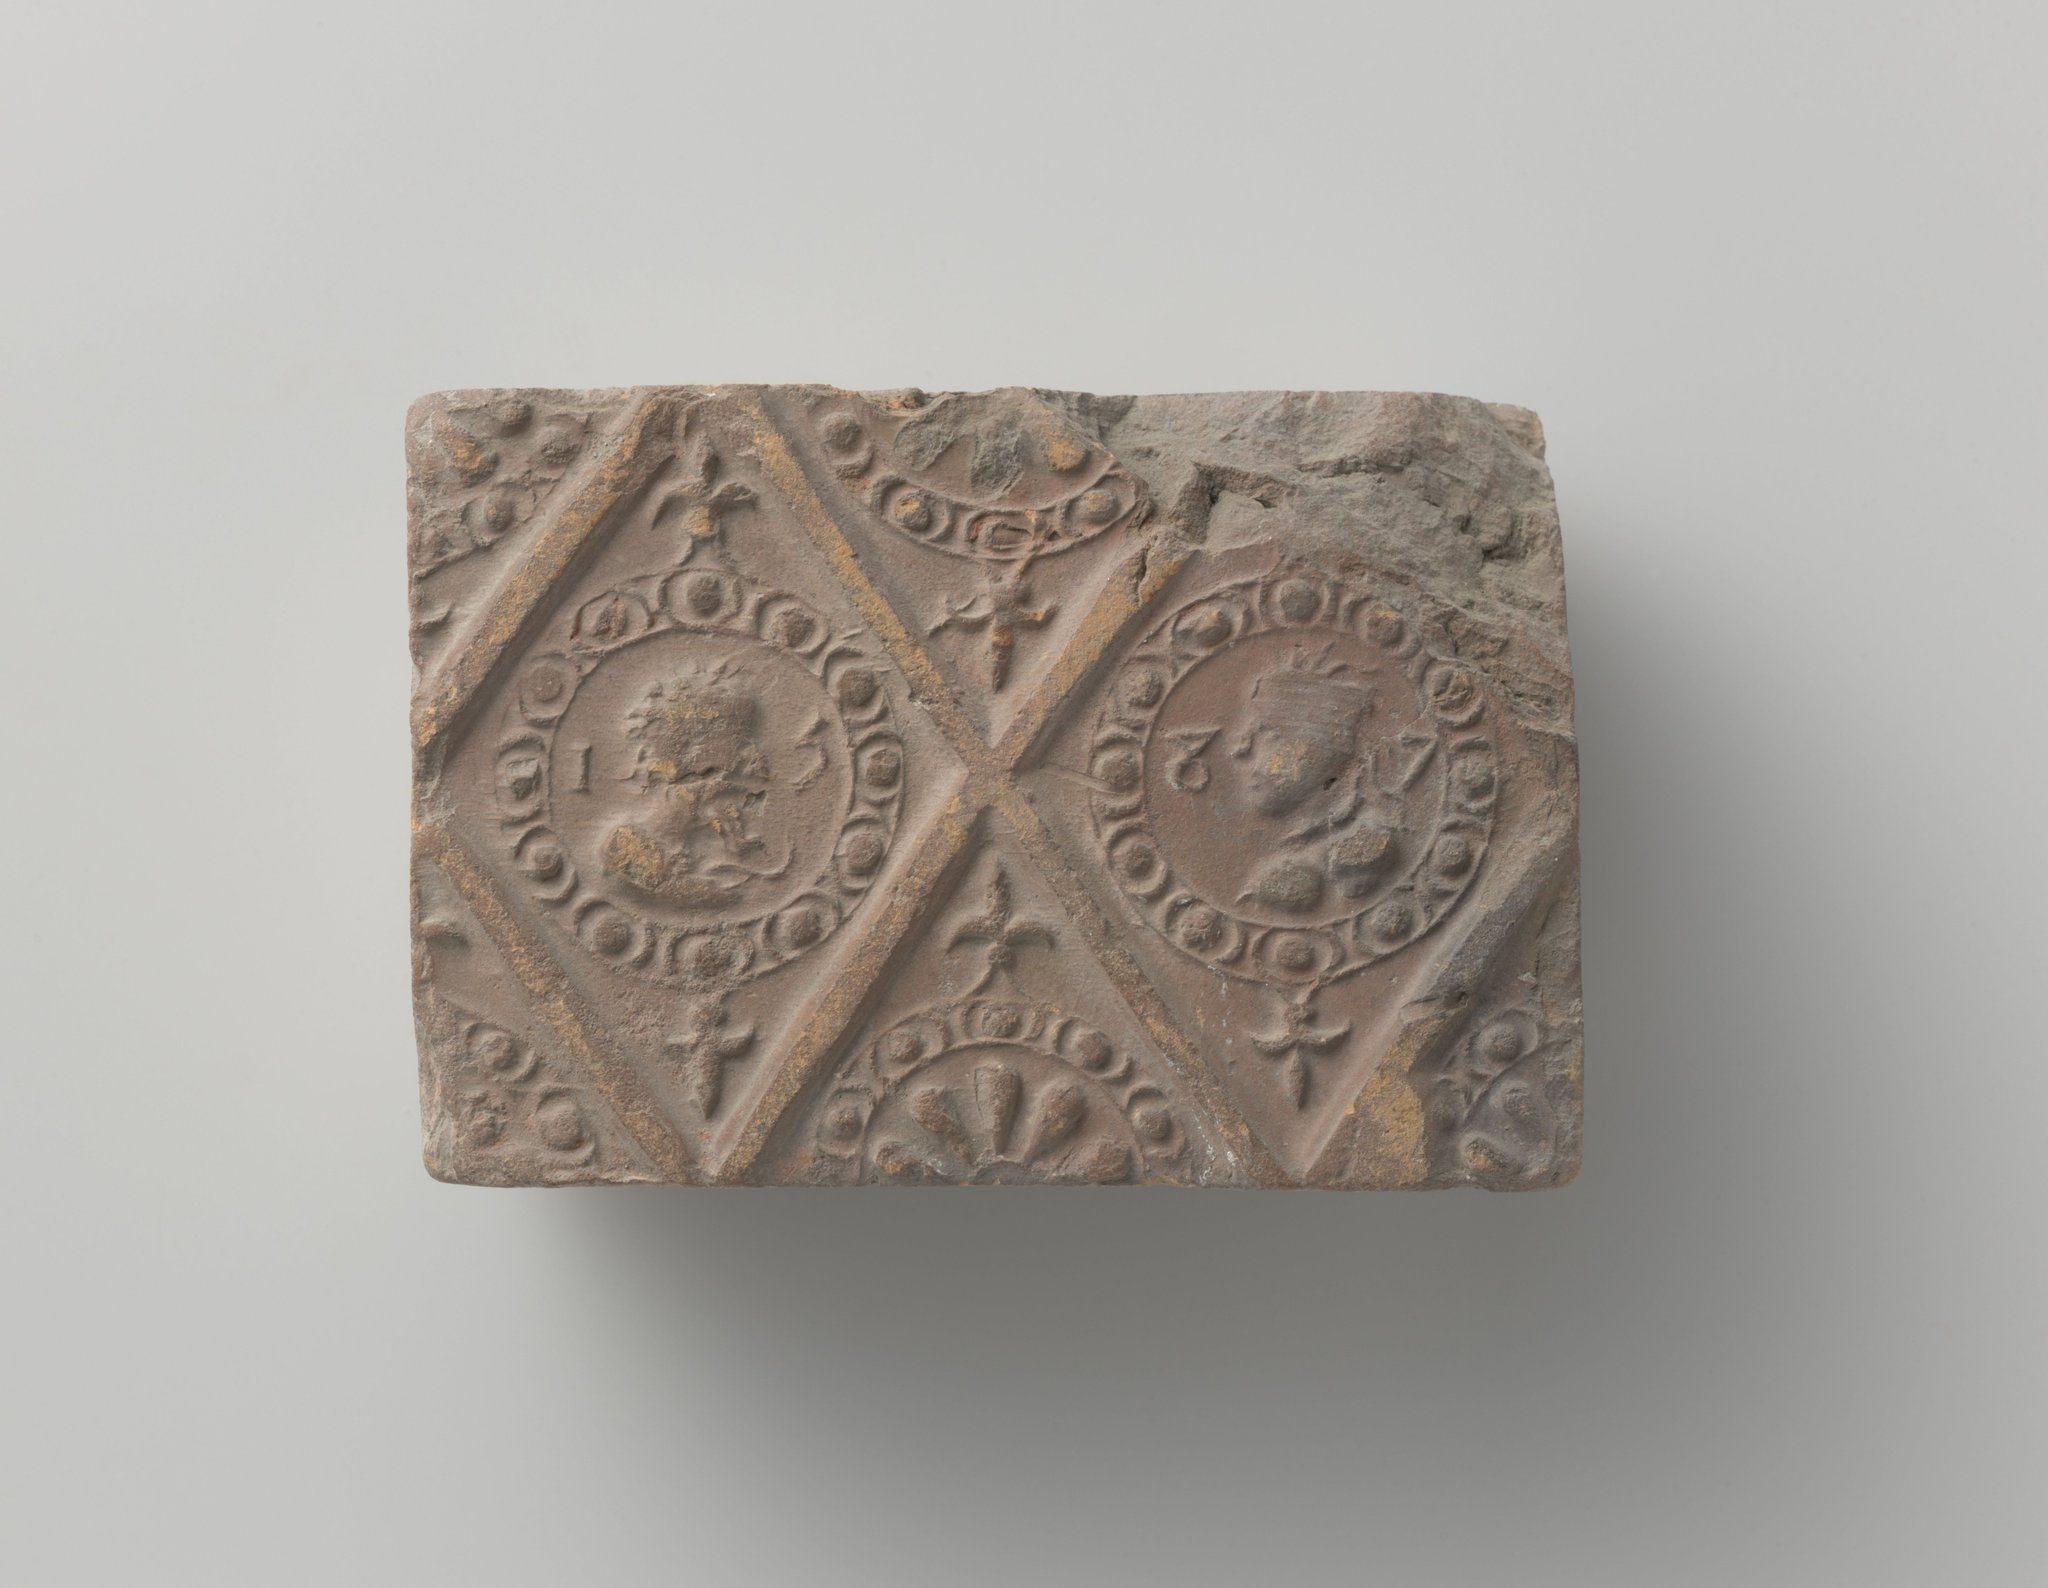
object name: sculpture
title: Haardsteen met afbeelding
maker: Anonymous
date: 1587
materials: earthenware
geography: southern netherlands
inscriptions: date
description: Haardsteen met een afbeelding van twee vorstelijke busten; een man en een vrouw en het jaartal 1587.